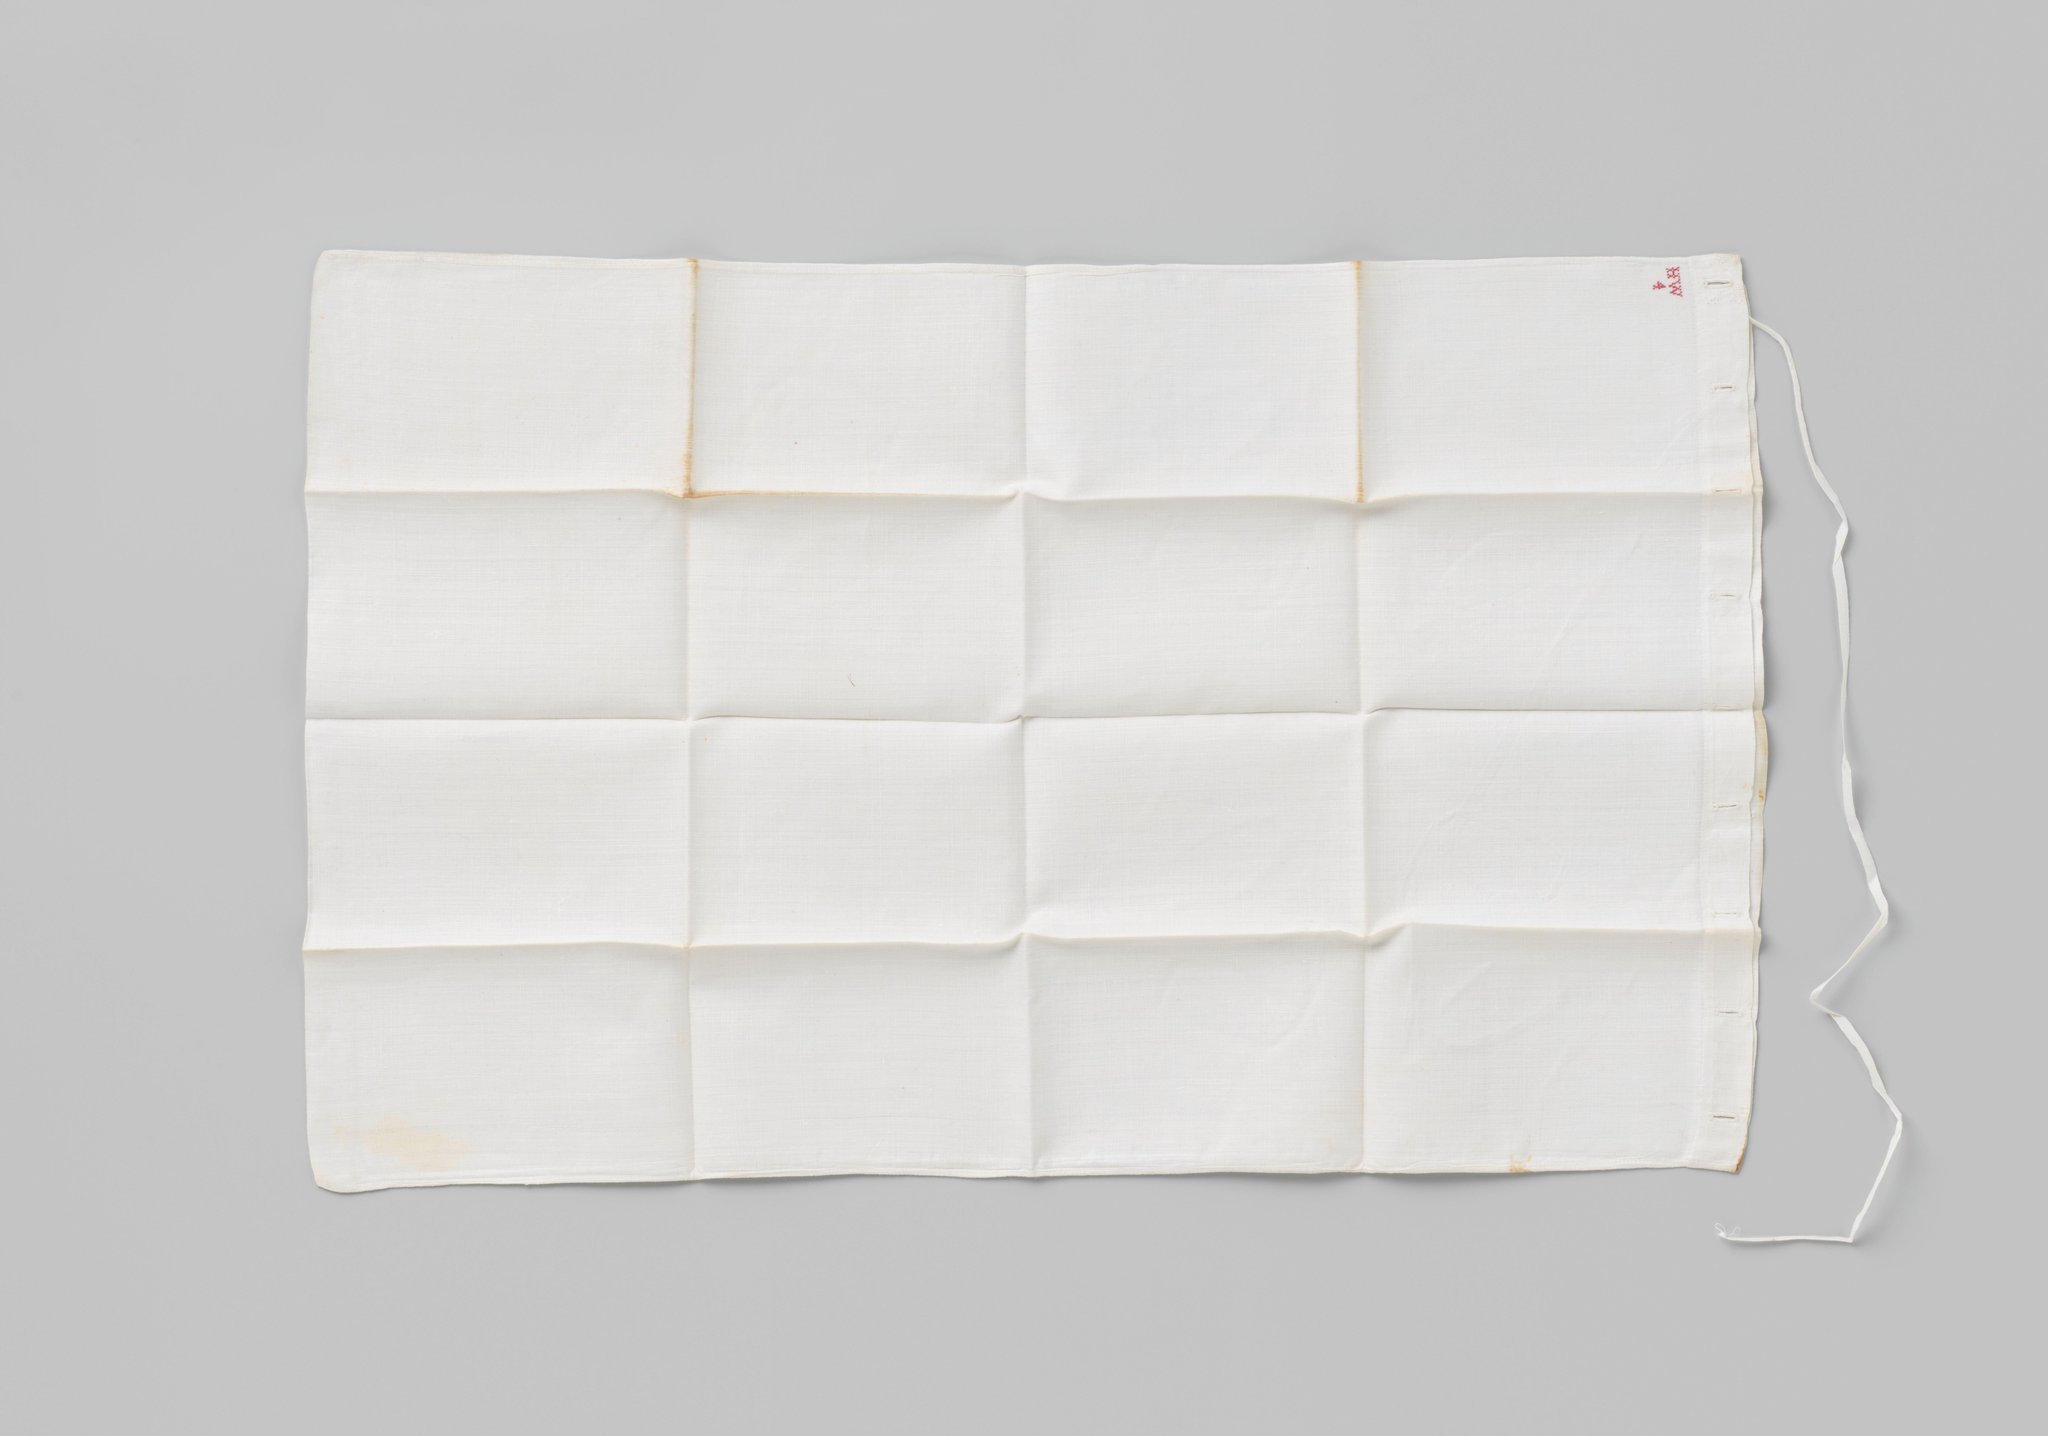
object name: lendensloop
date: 1692-1735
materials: linen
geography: northern netherlands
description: Lendensloop van linnen, merk kroon GS24 en HW4.